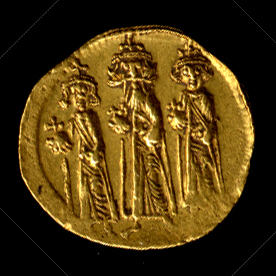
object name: solidus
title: Solidus of Heraclius, Heraclius Constantine, and Heraclonas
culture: byzantine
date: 638-641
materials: gold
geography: constantinople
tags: men,saints